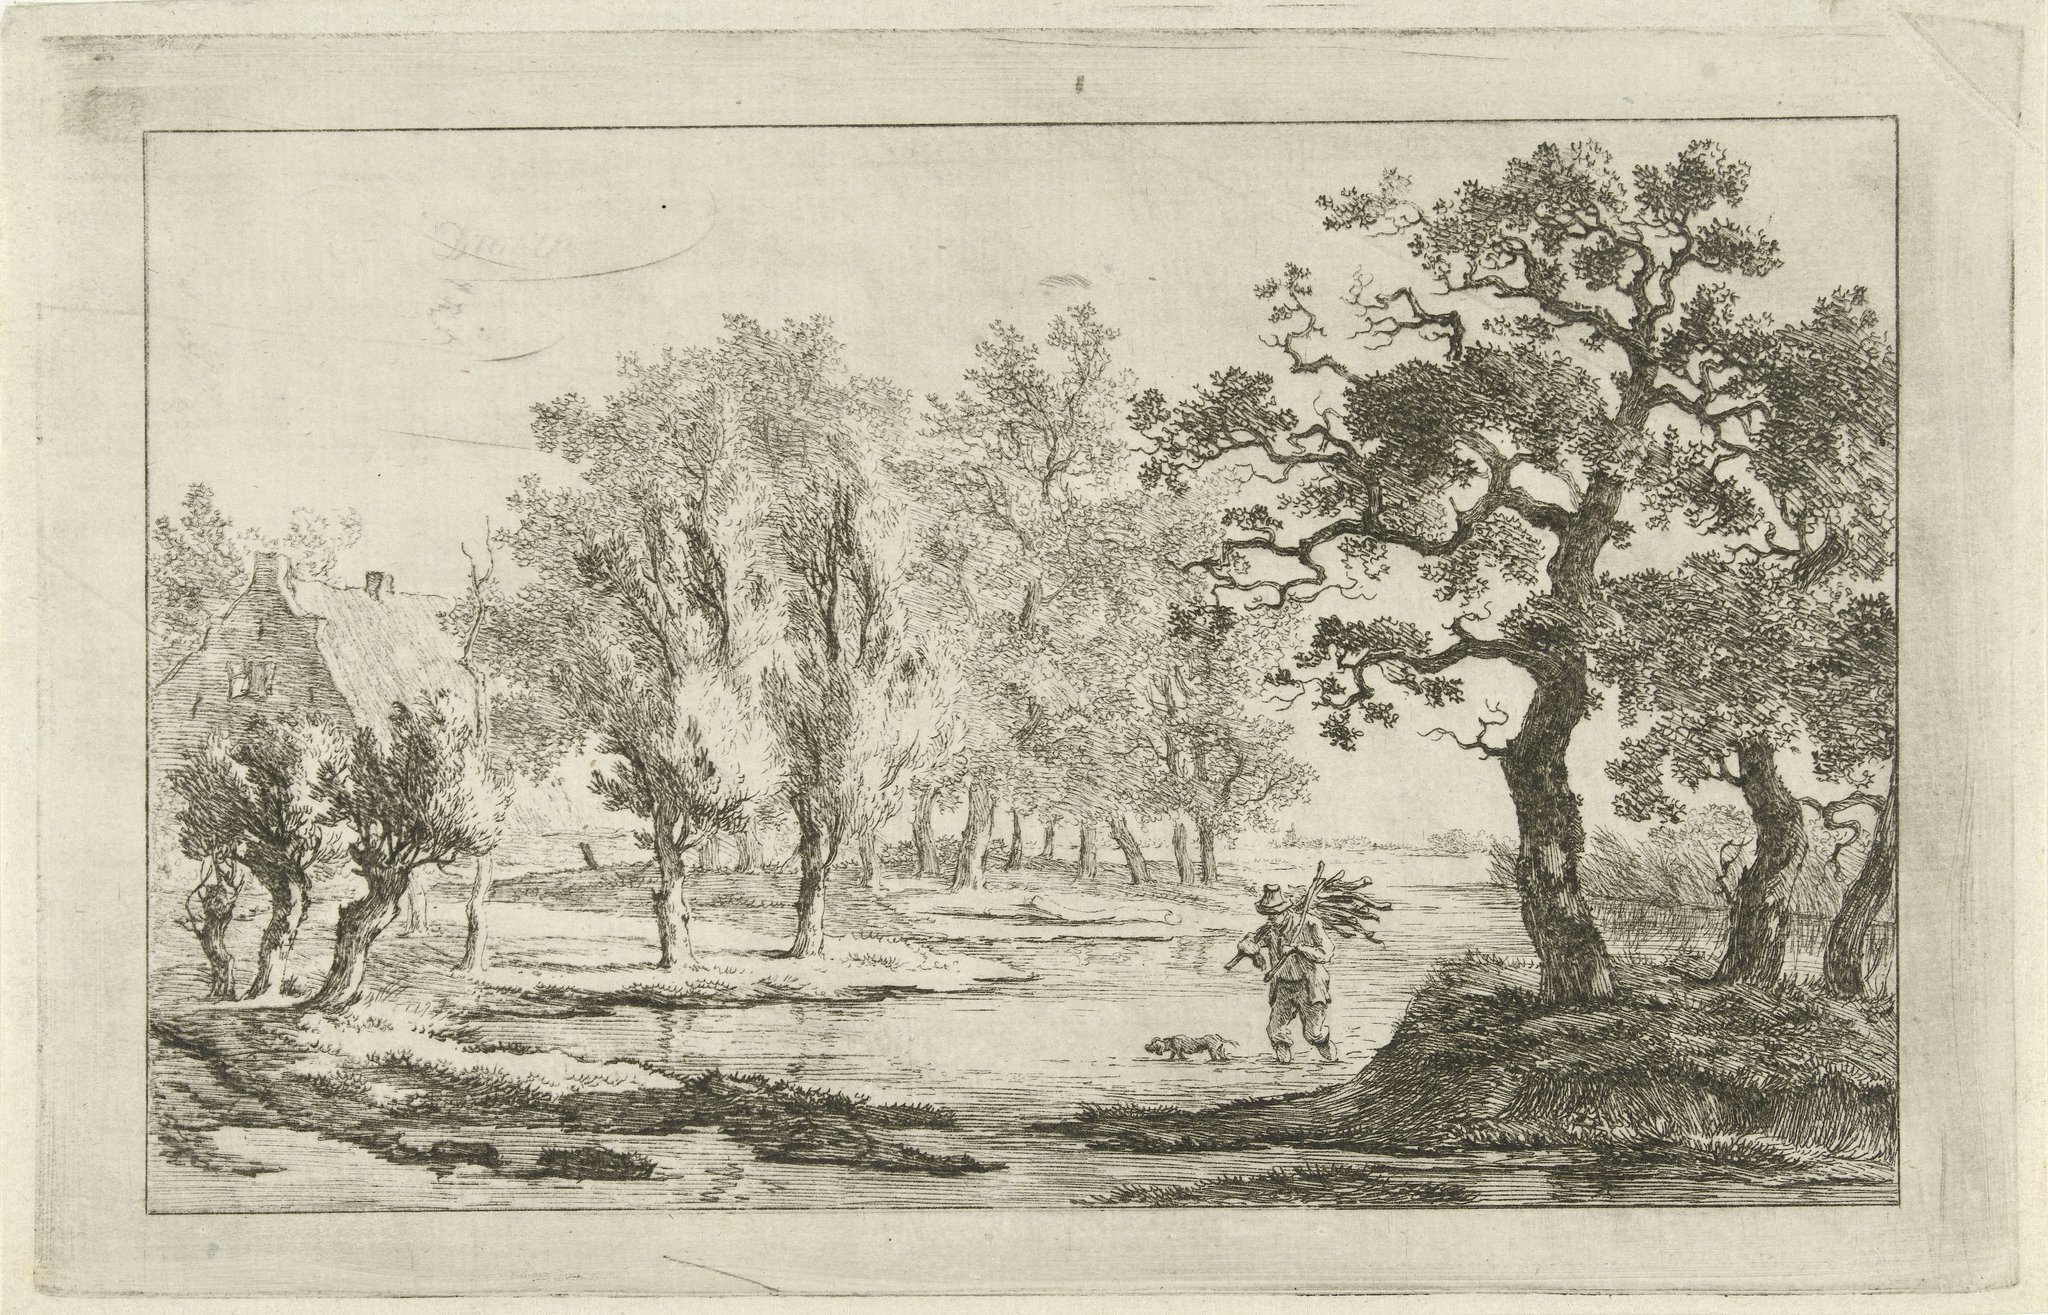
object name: print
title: Rivierlandschap met een houtsprokkelaar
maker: carel lodewijk hansen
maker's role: draughtsman, painter, print maker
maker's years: 1765-1840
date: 1780-1840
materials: paper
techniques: etching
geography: netherlands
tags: river, dog, woodgathering, woodgatherer (+ outdoors; in the open air)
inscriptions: collector's mark: Lugt 2228